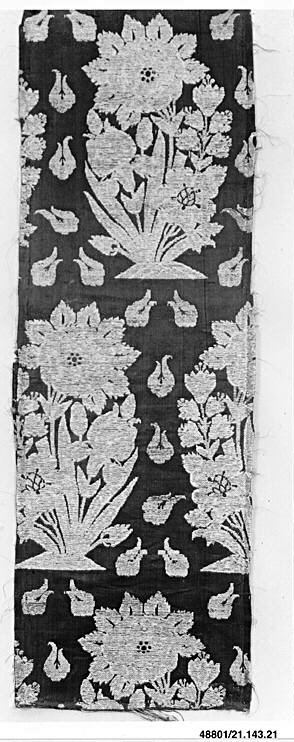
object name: brocade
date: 1600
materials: silk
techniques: brocade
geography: iran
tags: flowers